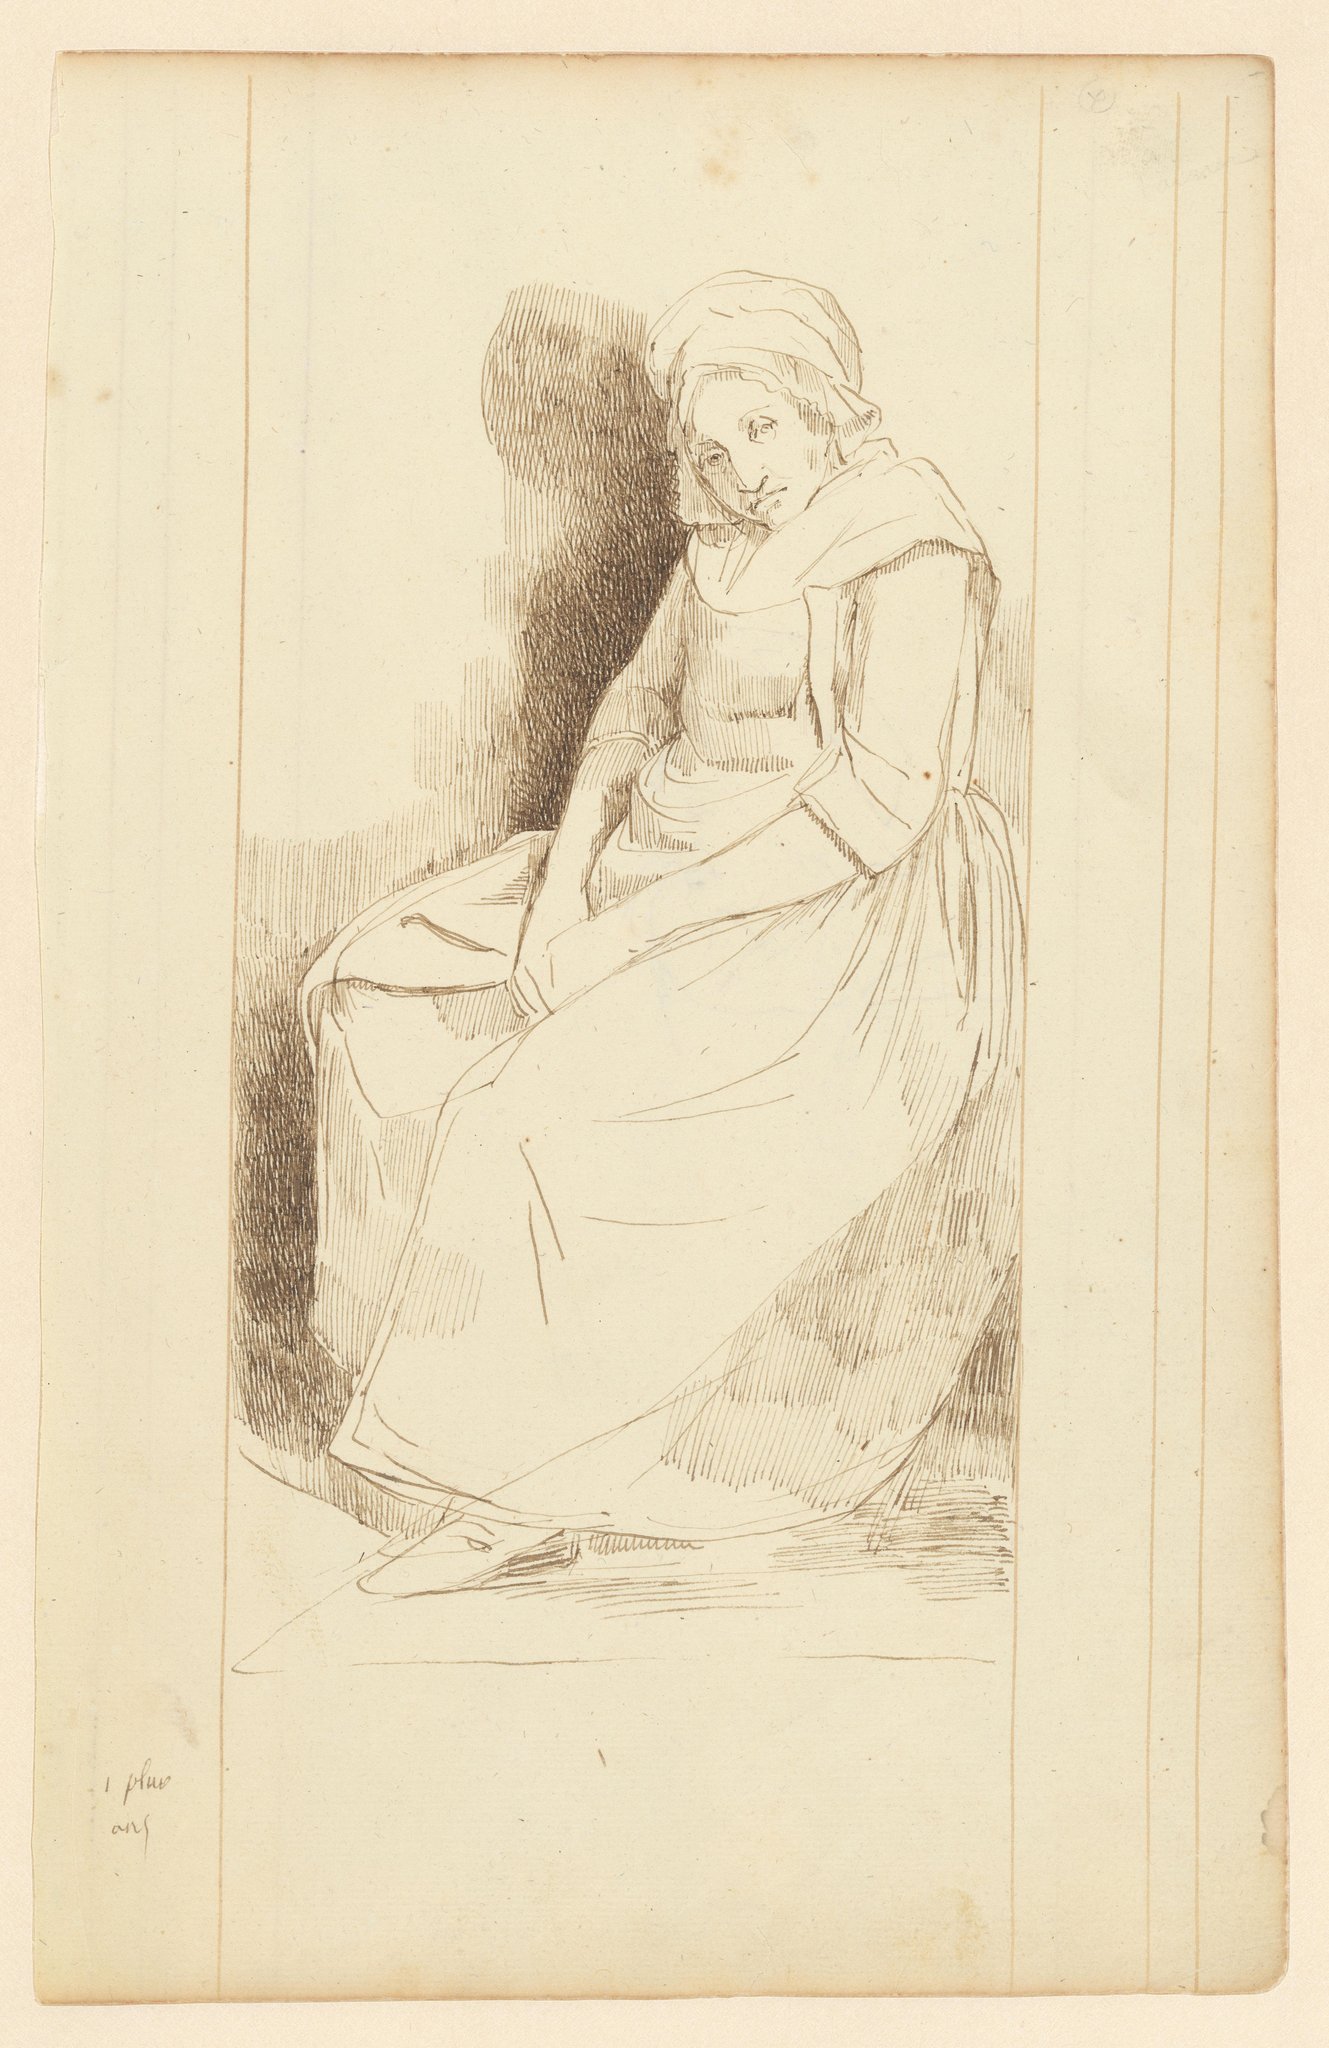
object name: drawing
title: Figuurstudie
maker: adélaïde-marie-anne moitte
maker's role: artist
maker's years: 1747-1807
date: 1797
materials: ink, paper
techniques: drawing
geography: paris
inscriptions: date